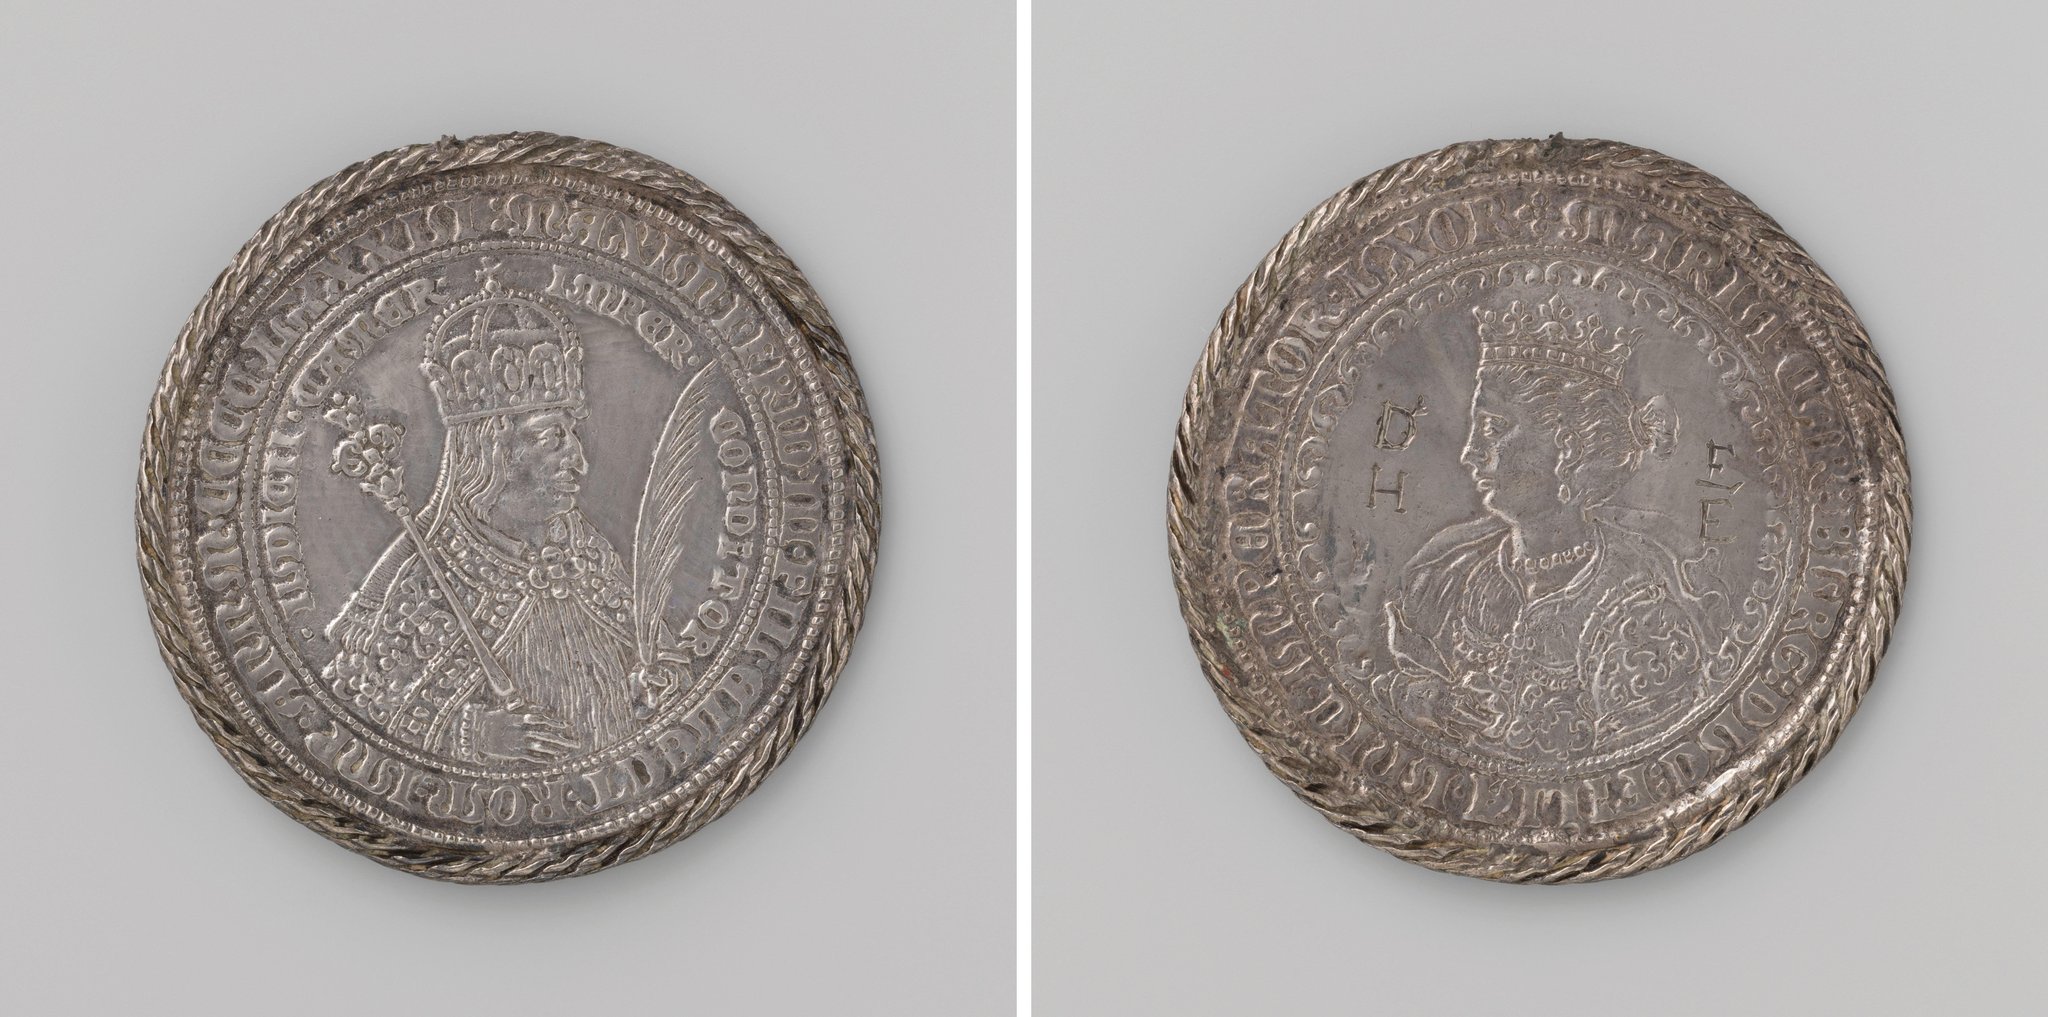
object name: copy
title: Maximiliaan, aartshertog van Oostenrijk gekroond tot Rooms koning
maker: Anonymous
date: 1486-1506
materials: silver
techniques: striking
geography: hall am inn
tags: brussels, bruges, maria (hertogin van bourgondië), maximilian i (holy roman emperor)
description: Zilveren penning in kabelrand. Voorzijde: borststuk man met kroon, scepter en palmtak binnen tweeregelig omschrift. Keerzijde: borststuk vrouw met kroon en vogel in rechterhand tussen monogrammen binnen sierrand en omschrift